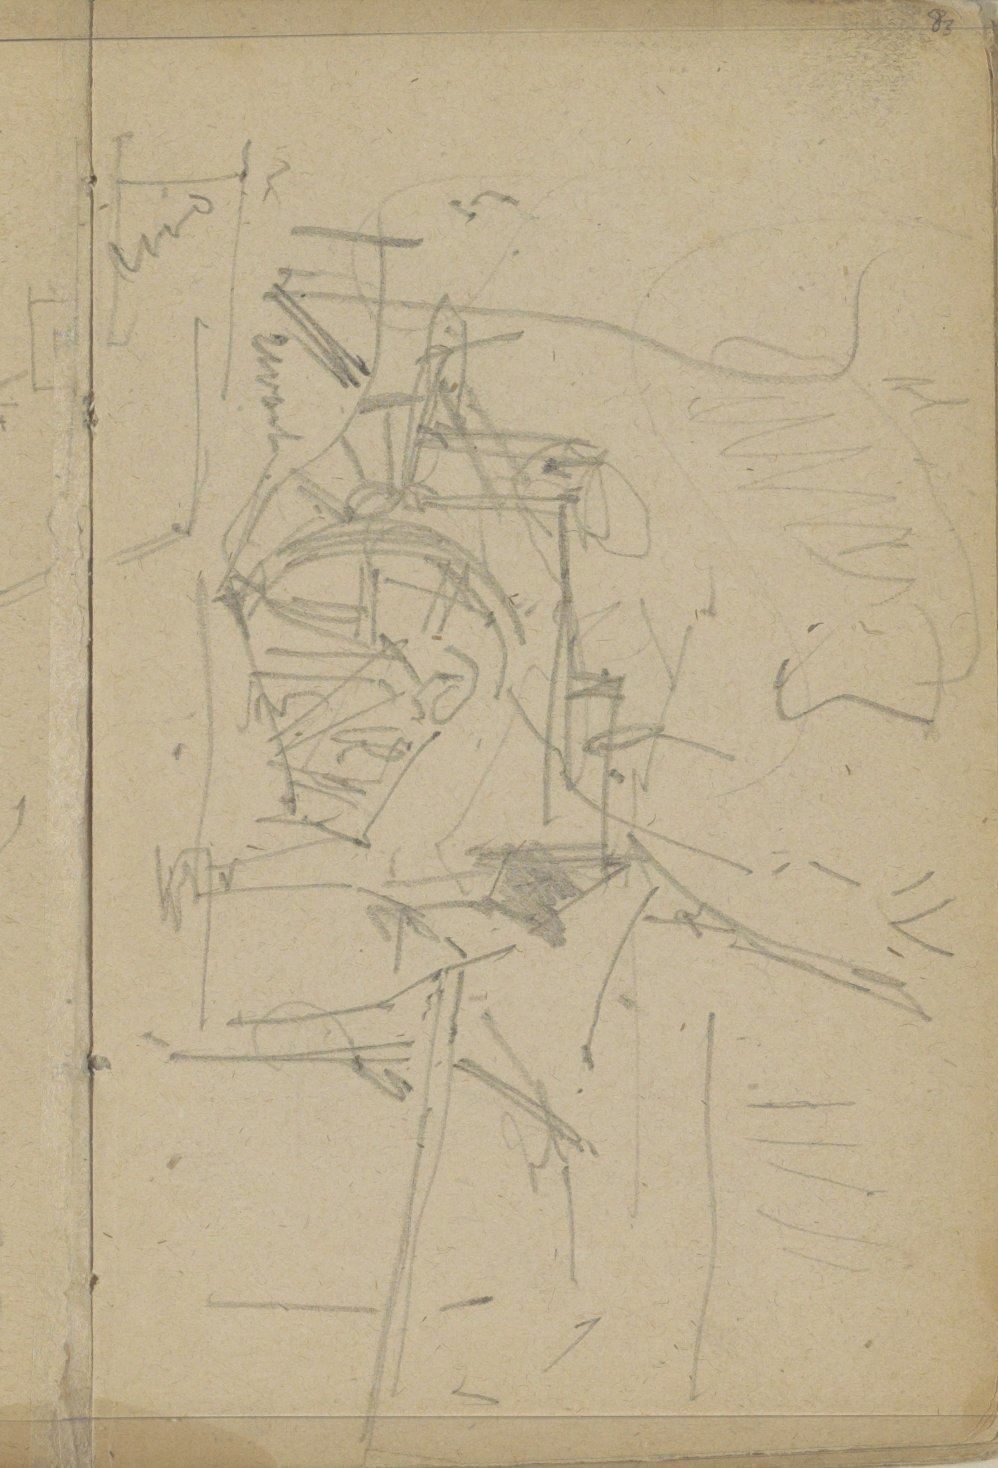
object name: sketchbook leaf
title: Handkar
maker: george hendrik breitner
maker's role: draughtsman, painter, print maker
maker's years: 1857-1923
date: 1881-1883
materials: paper, pencil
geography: south holland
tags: hand-cart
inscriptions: kleurnotitie, handgeschreven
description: Handkar. Pagina 83 uit een schetsboek met 70 bladen.